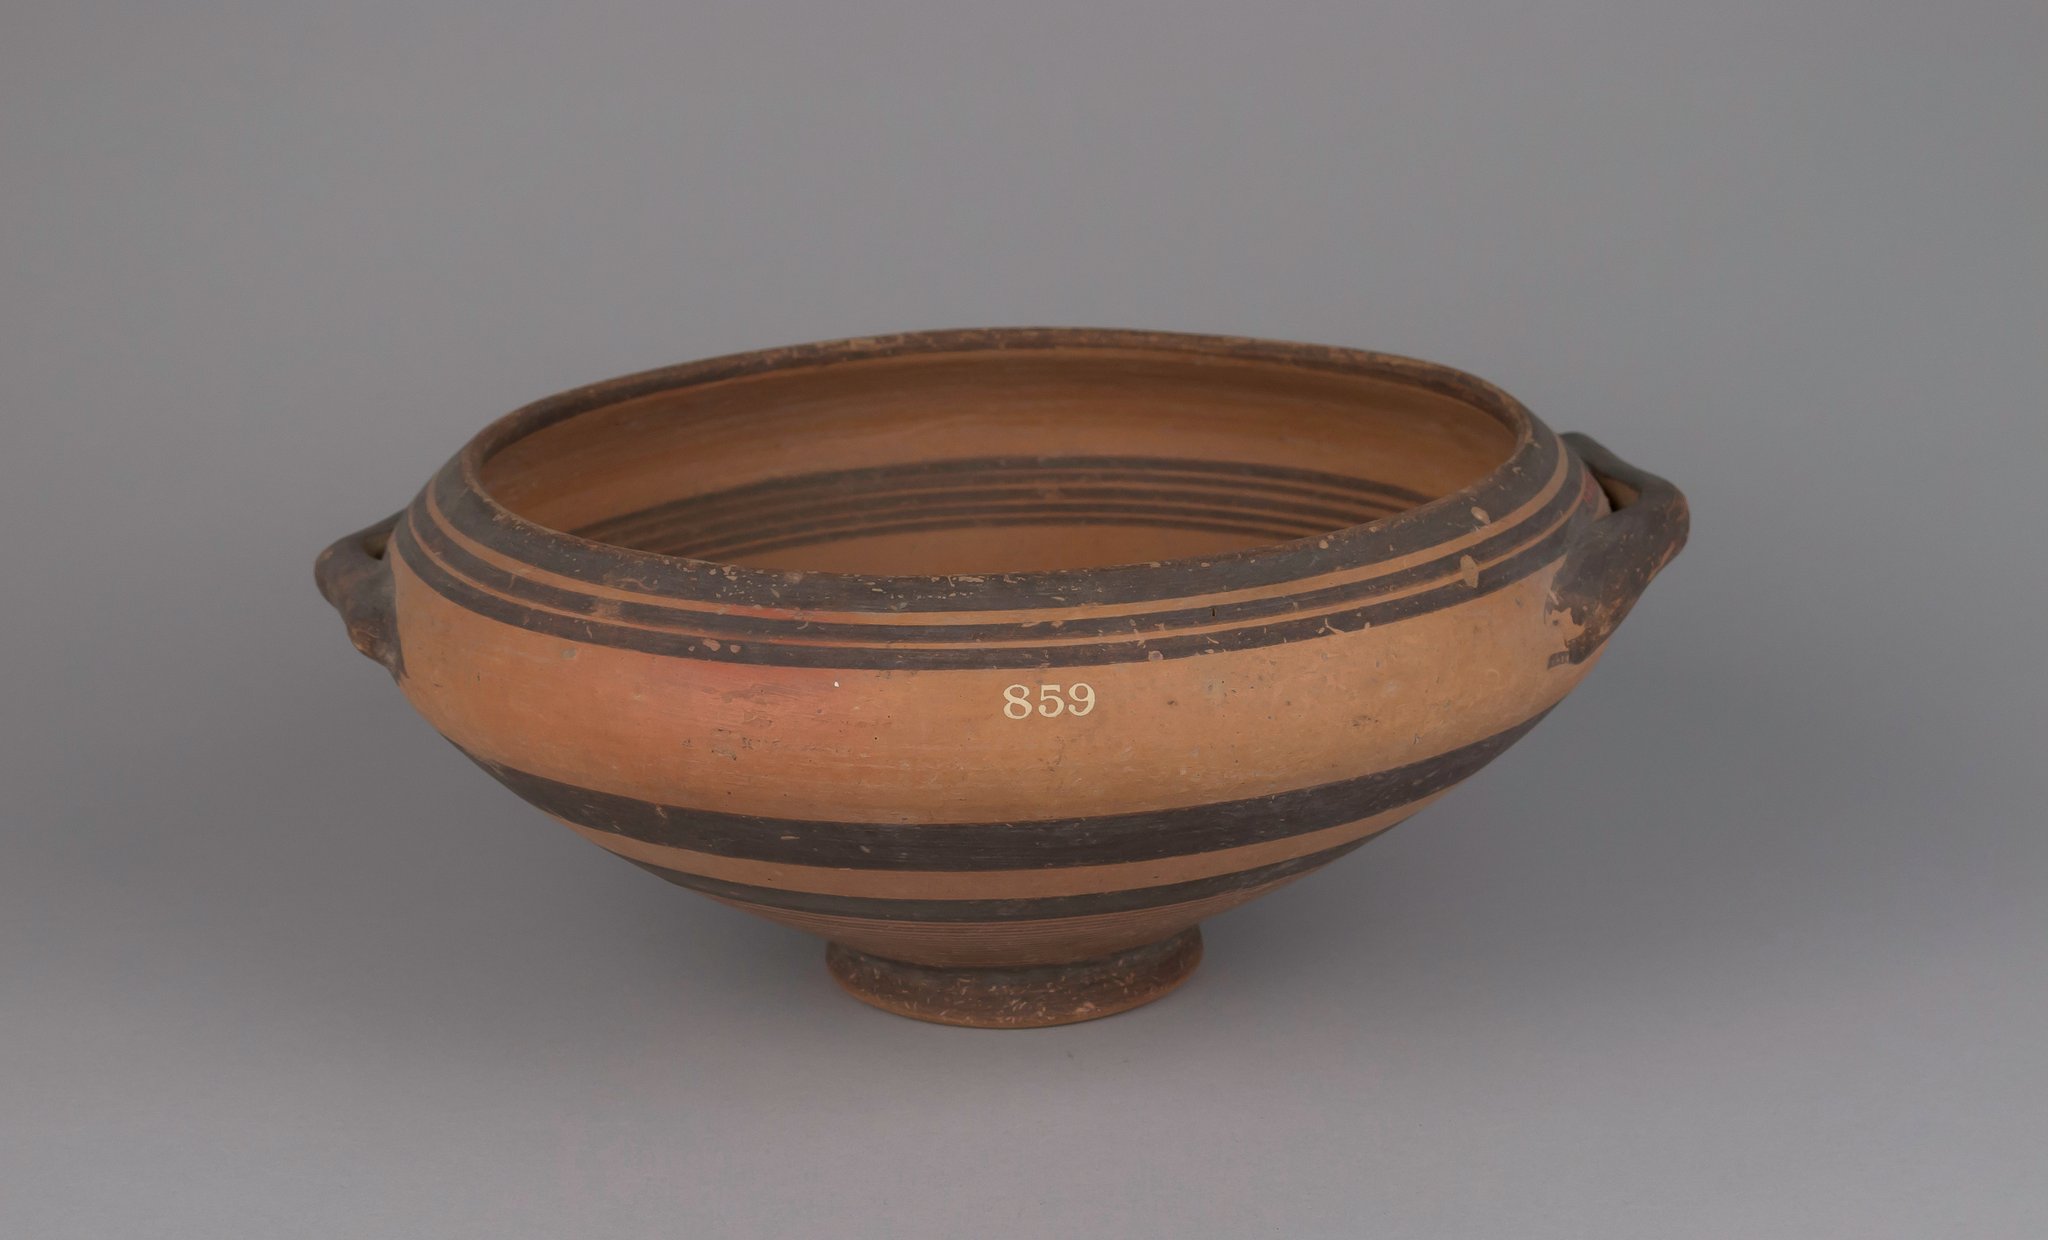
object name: bowl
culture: cypriot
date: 850-750 BCE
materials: terracotta